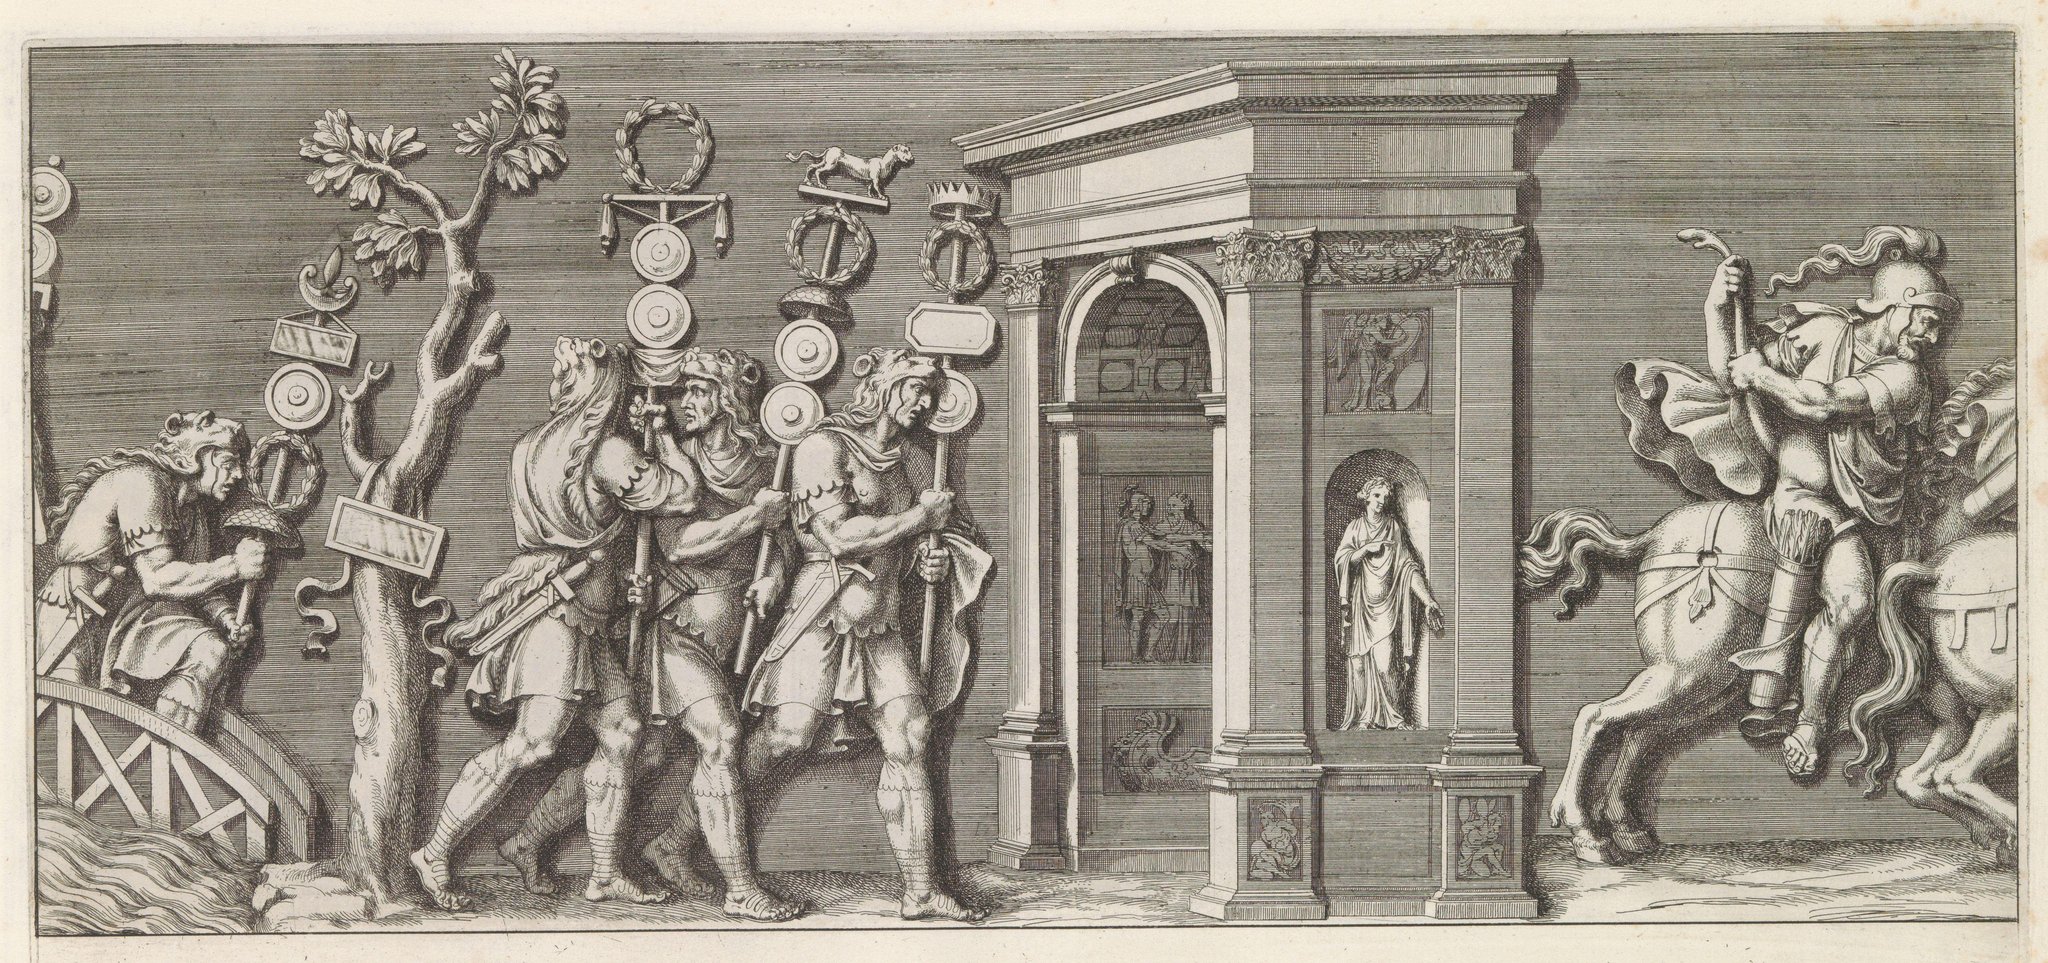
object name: album leaf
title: Deel van een triomfprocessie en een triomfboog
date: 1680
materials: paper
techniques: etching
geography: mantua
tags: triumphal arch, triumphal entry and public reception, pageant, 'entrée solennelle', 'joyeuse entrée', military parade, pageant, the soldier; the soldier's life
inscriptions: number: ‘10’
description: Prent maakt deel uit van een reeks van 25 prenten (+ titelprent) naar het stucwerk door Giulio Romano en Francesco Primaticcio in de Sala degli Stucchi in Palazzo del Te te Mantua.